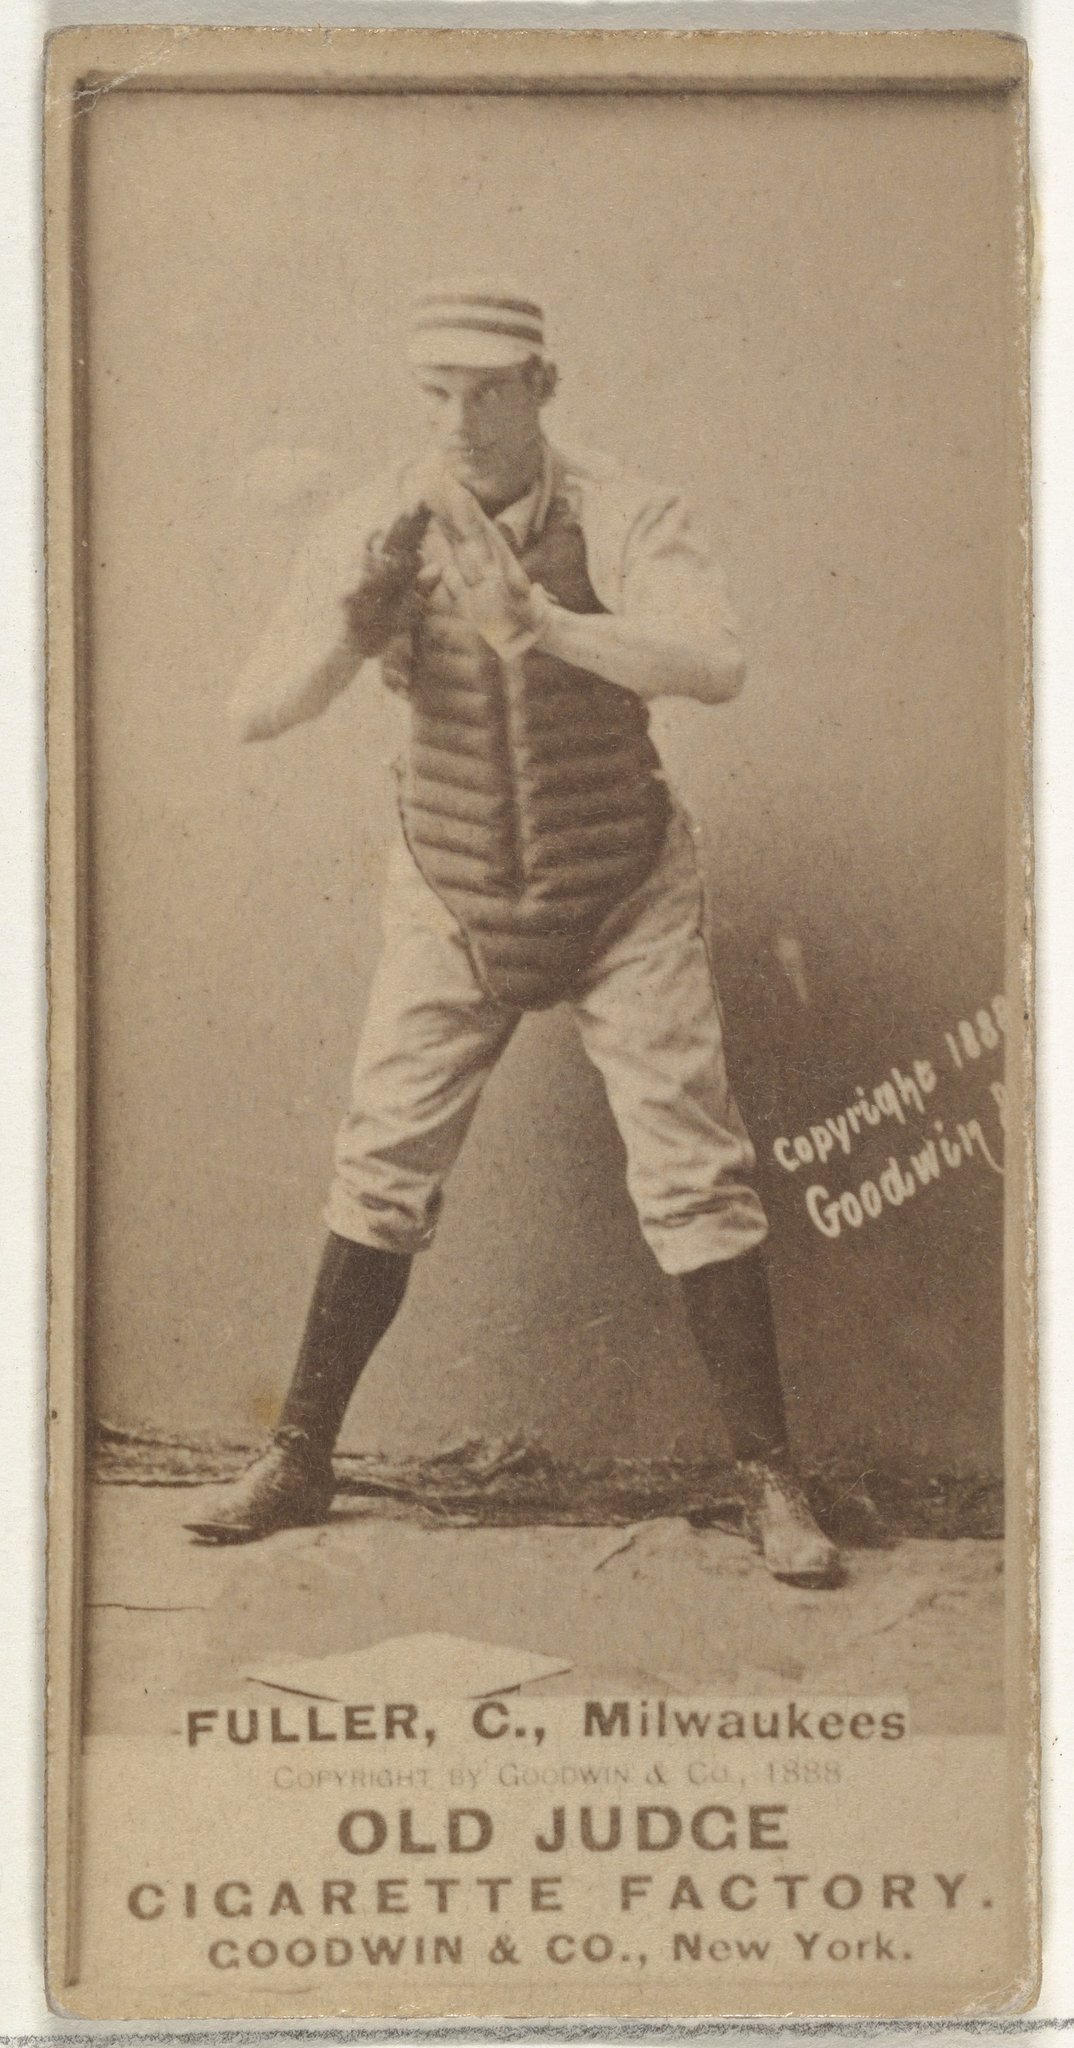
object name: baseball card, photograph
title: William E. "Will" Fuller, Catcher, Milwaukee, from the Old Judge series (N172) for Old Judge Cigarettes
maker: goodwin & company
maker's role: publisher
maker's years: 1850-1950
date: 1888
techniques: albumen silver print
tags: men,portraits,baseball,athletes